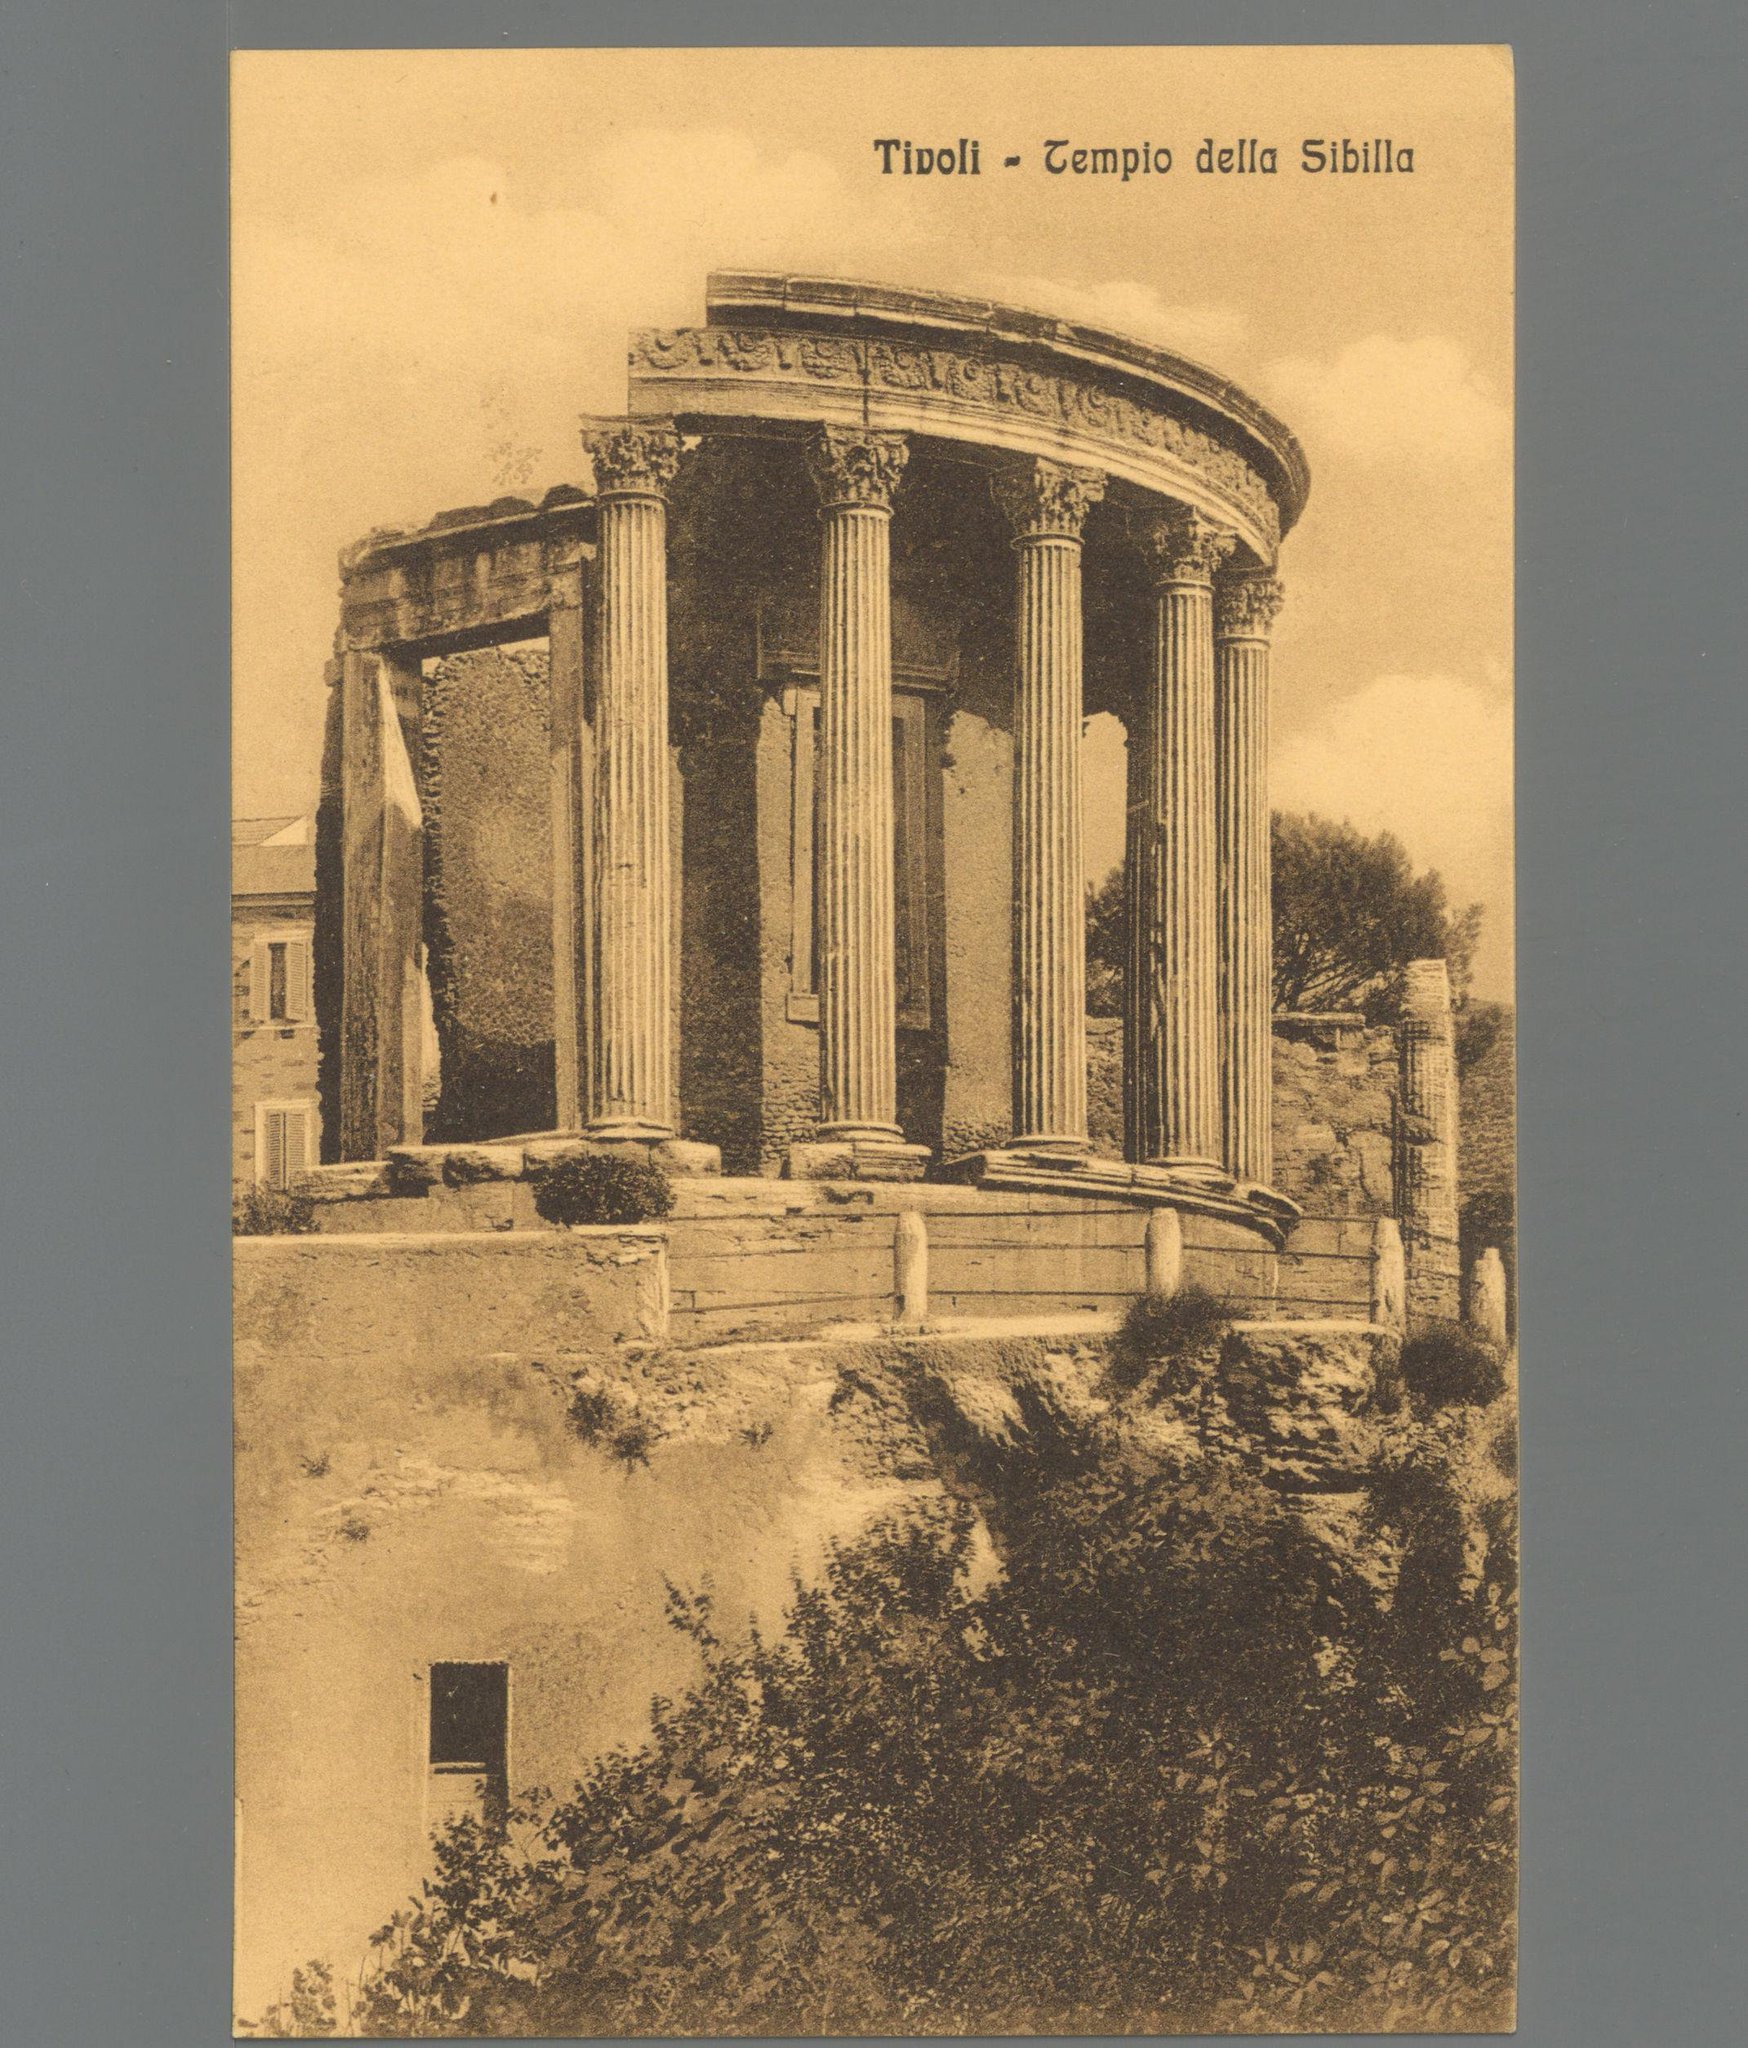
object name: ansichtkaart, prentbriefkaart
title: Tivoli. Tempio della Sibilla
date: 1906-1920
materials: cardboard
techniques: photograph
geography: tivoli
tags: ruin of a building ~ architecture, temple, shrine ~ roman religion